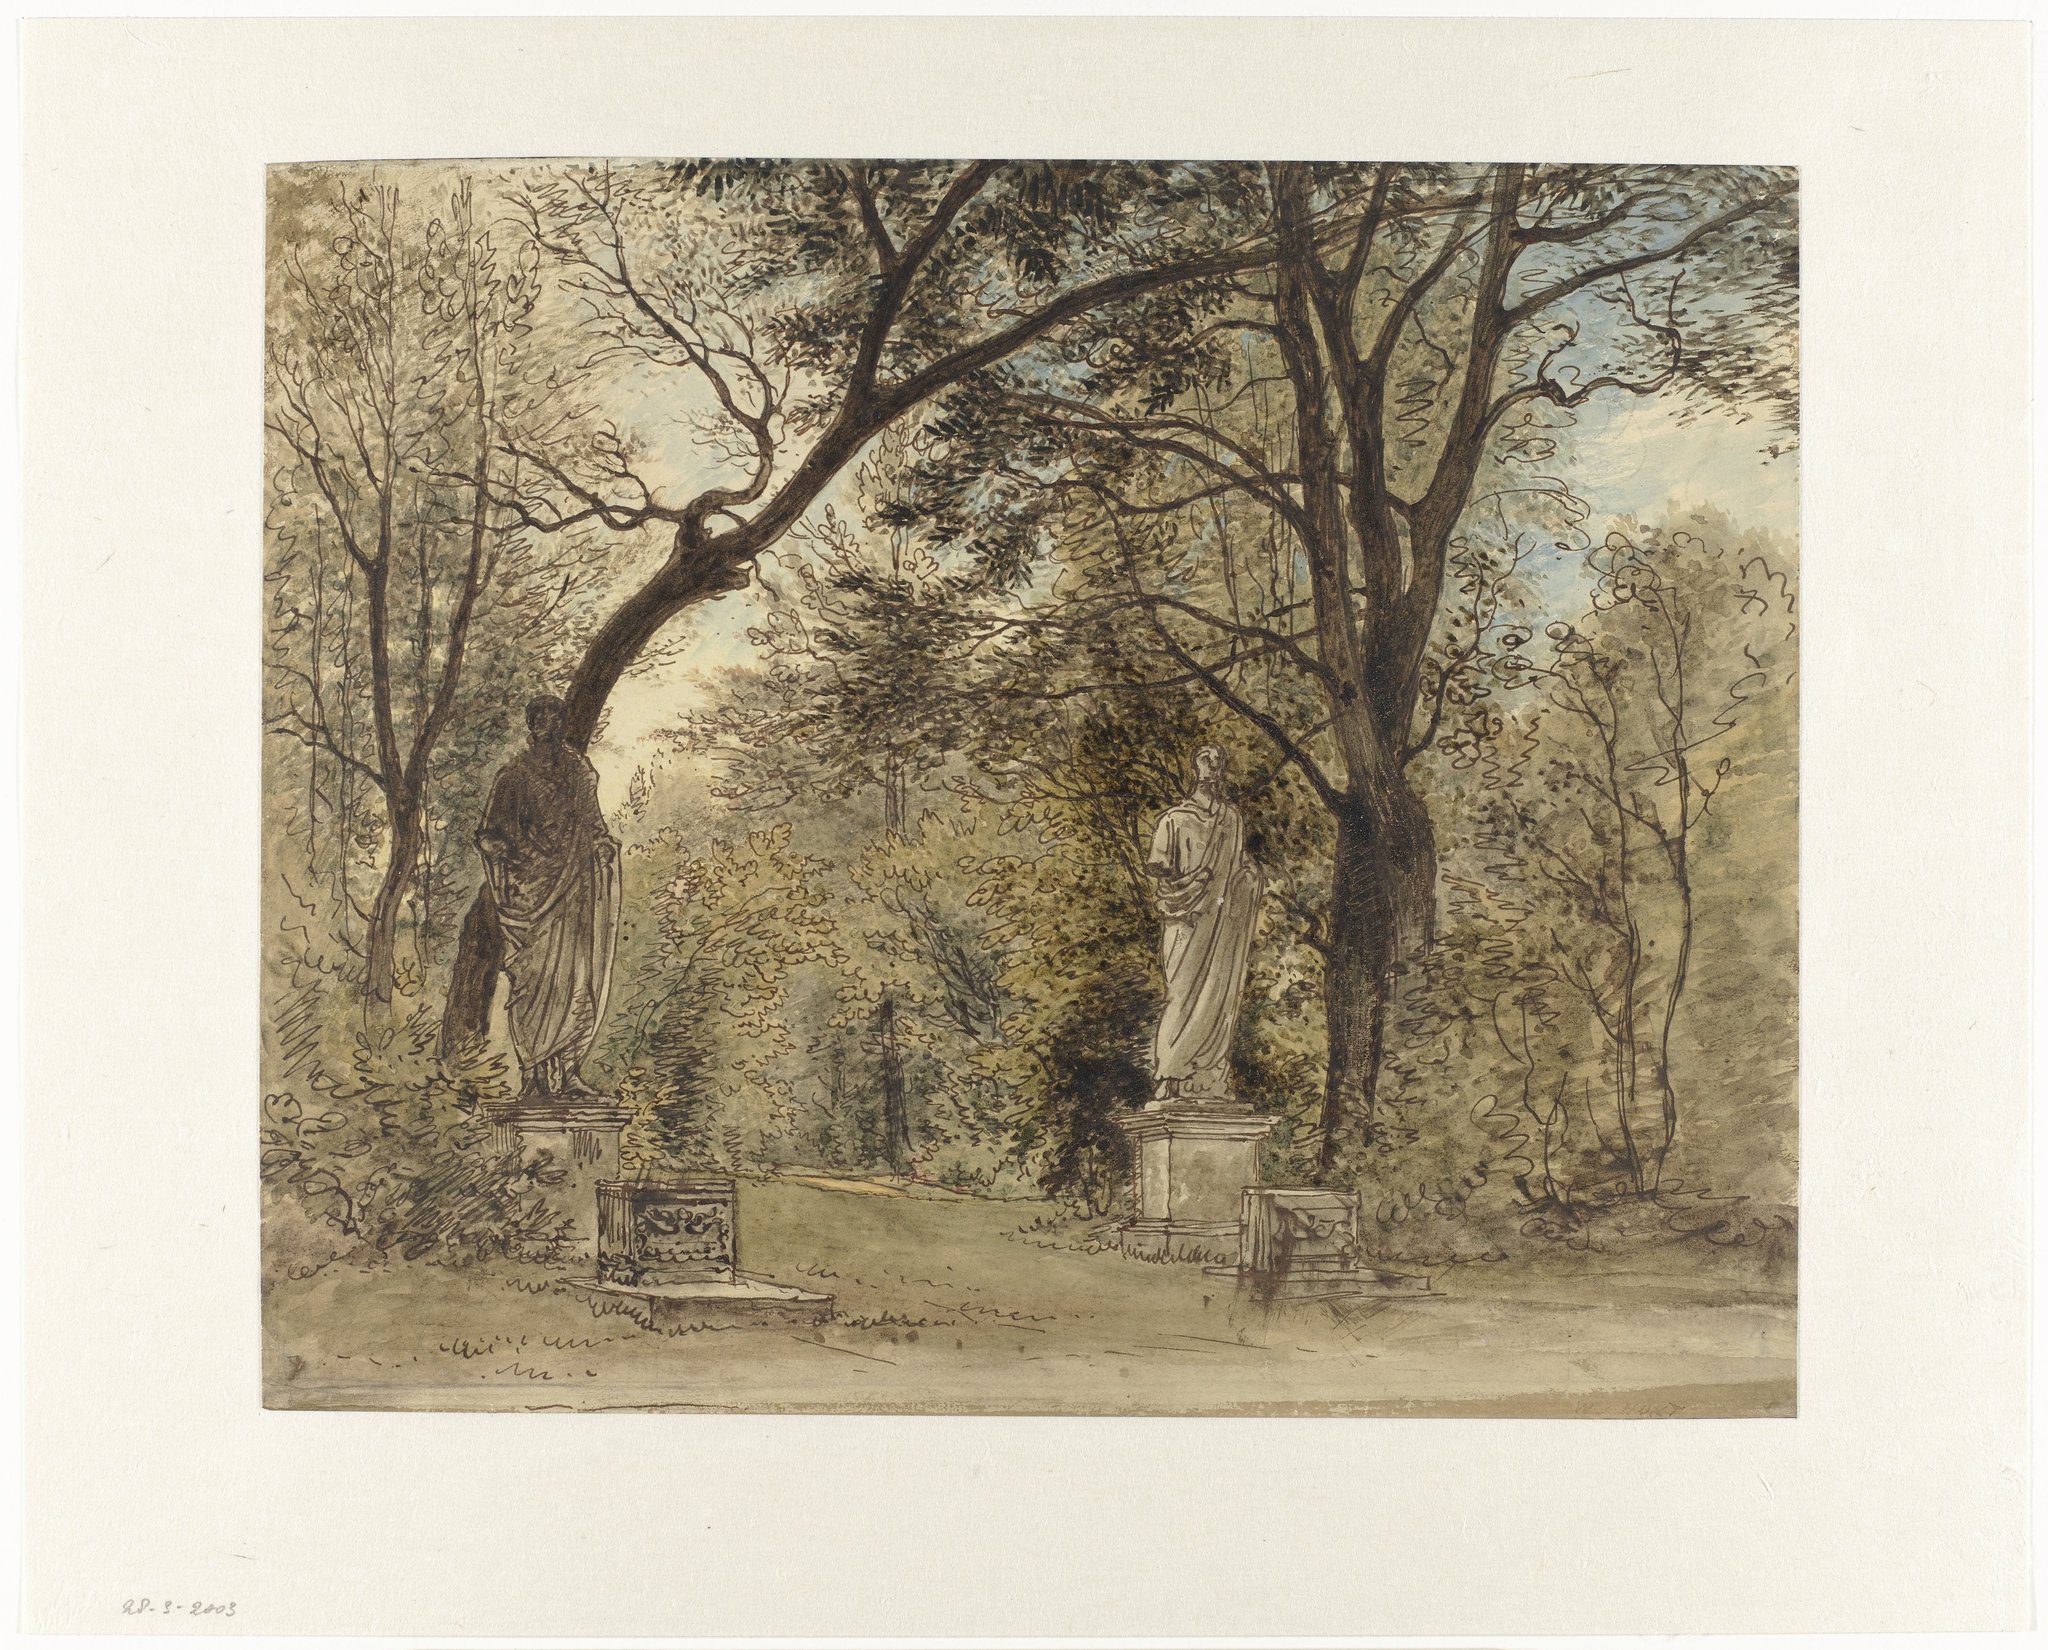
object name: drawing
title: Tuinbeelden in Chiswick Park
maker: william henry hunt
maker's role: draughtsman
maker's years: 1790-1864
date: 1800-1864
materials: ink, paper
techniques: brush, pen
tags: public gardens, park, statues, sculptures in garden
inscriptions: signature: ‘W. Hunt’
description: Deze beelden staan nu in de tuinen behorend bij Chiswick House.